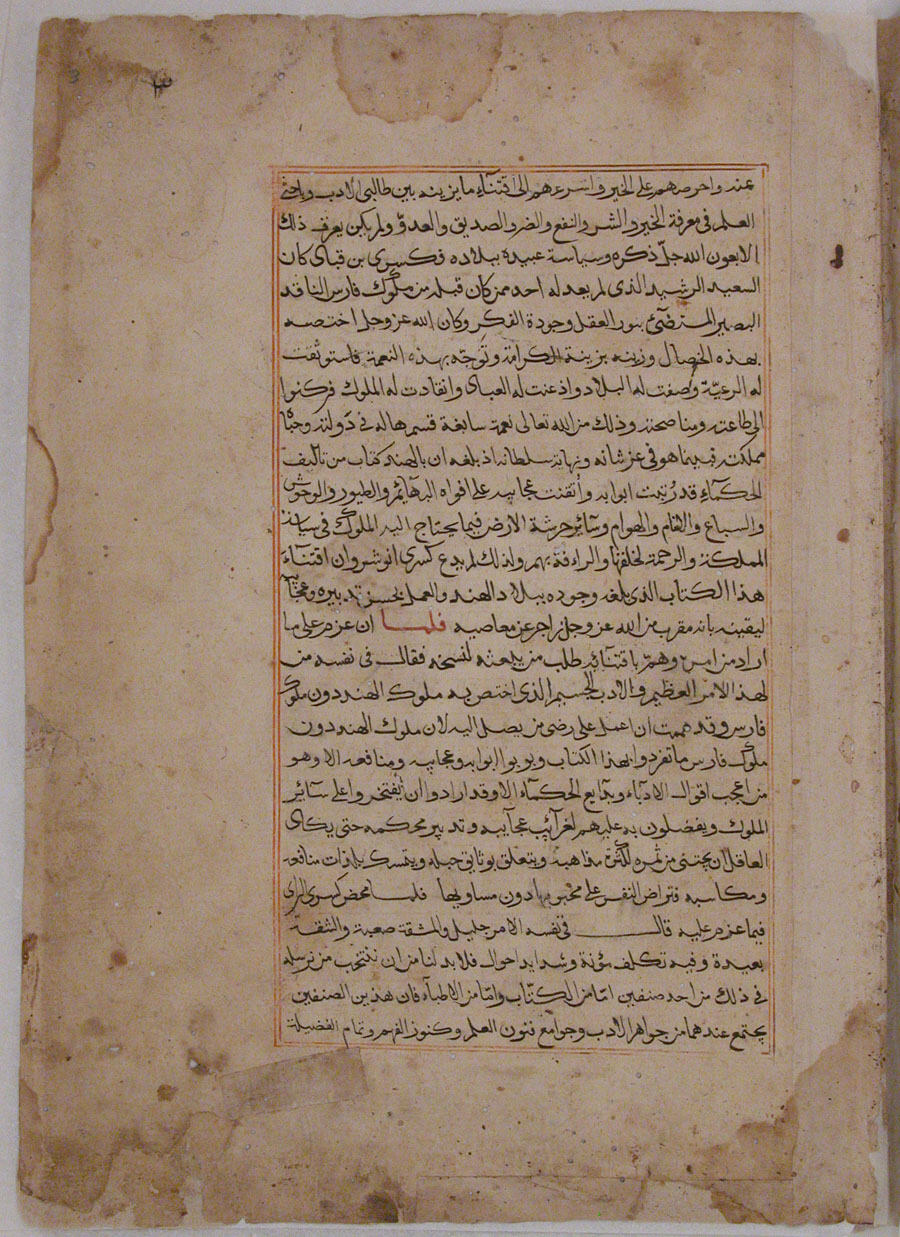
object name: folio from an illustrated manuscript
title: Page of Calligraphy from a from a Kalila wa Dimna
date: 1526-1550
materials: ink, paper, watercolor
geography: india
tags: arabic,calligraphy